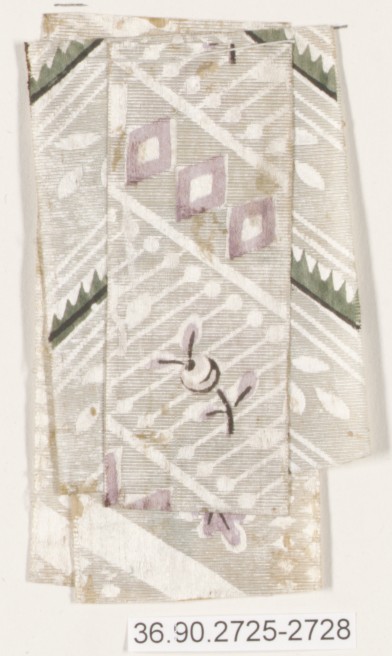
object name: ribbon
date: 1801-1900